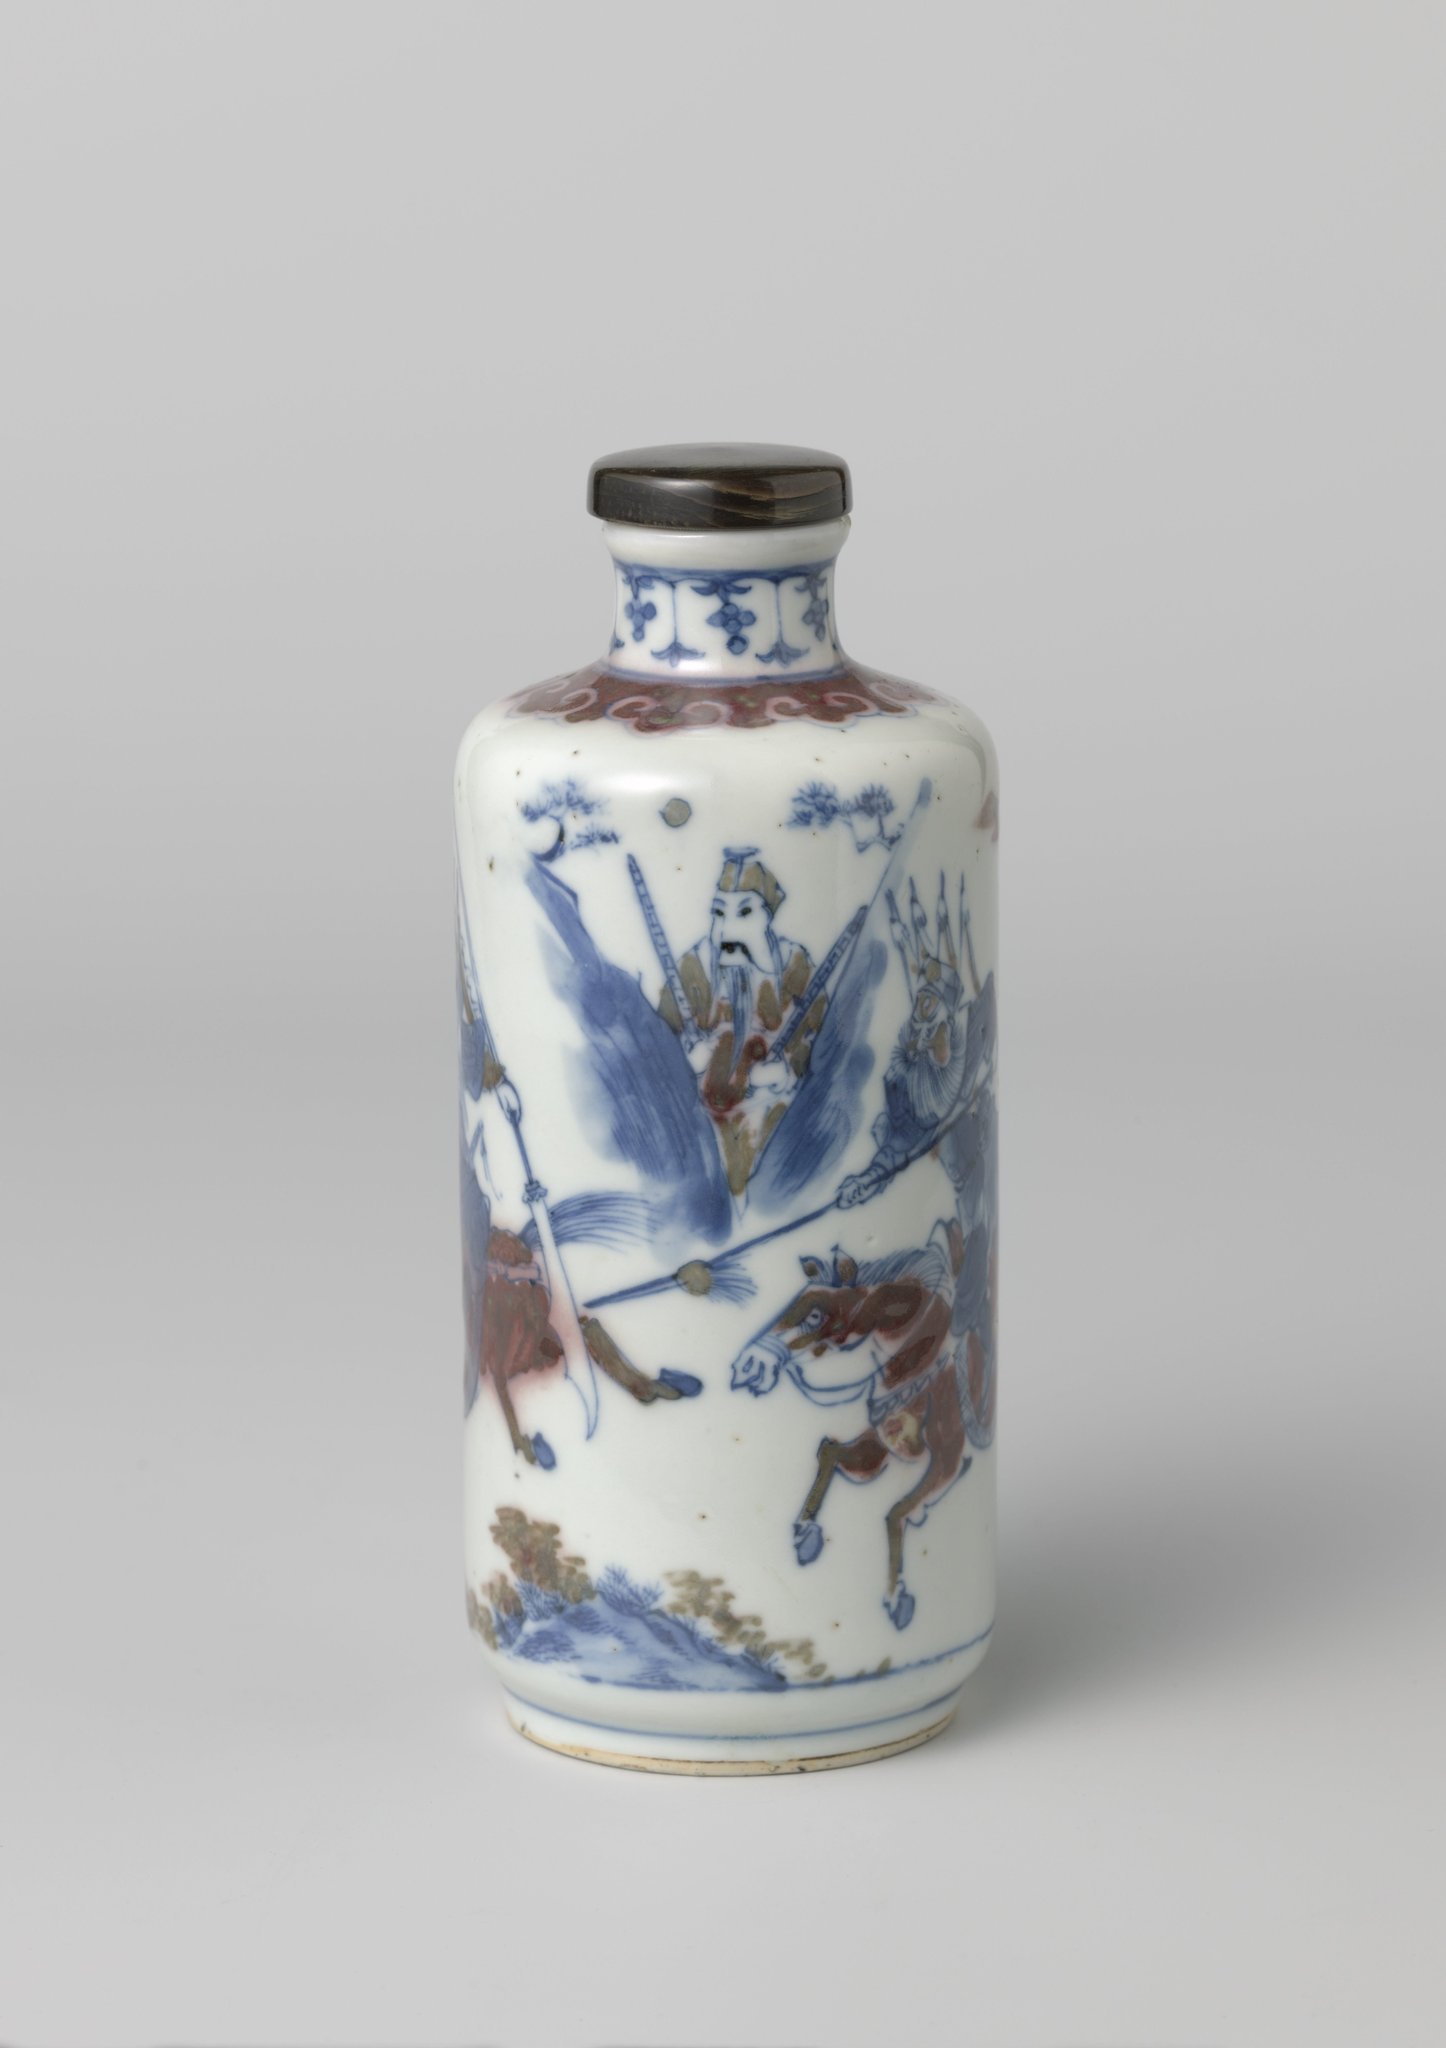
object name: bottle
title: Cylindrical bottle vase with warriors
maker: Anonymous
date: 1800-1924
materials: cobalt, copper, glaze, paint, porcelain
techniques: firing, turning, vitrification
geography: china